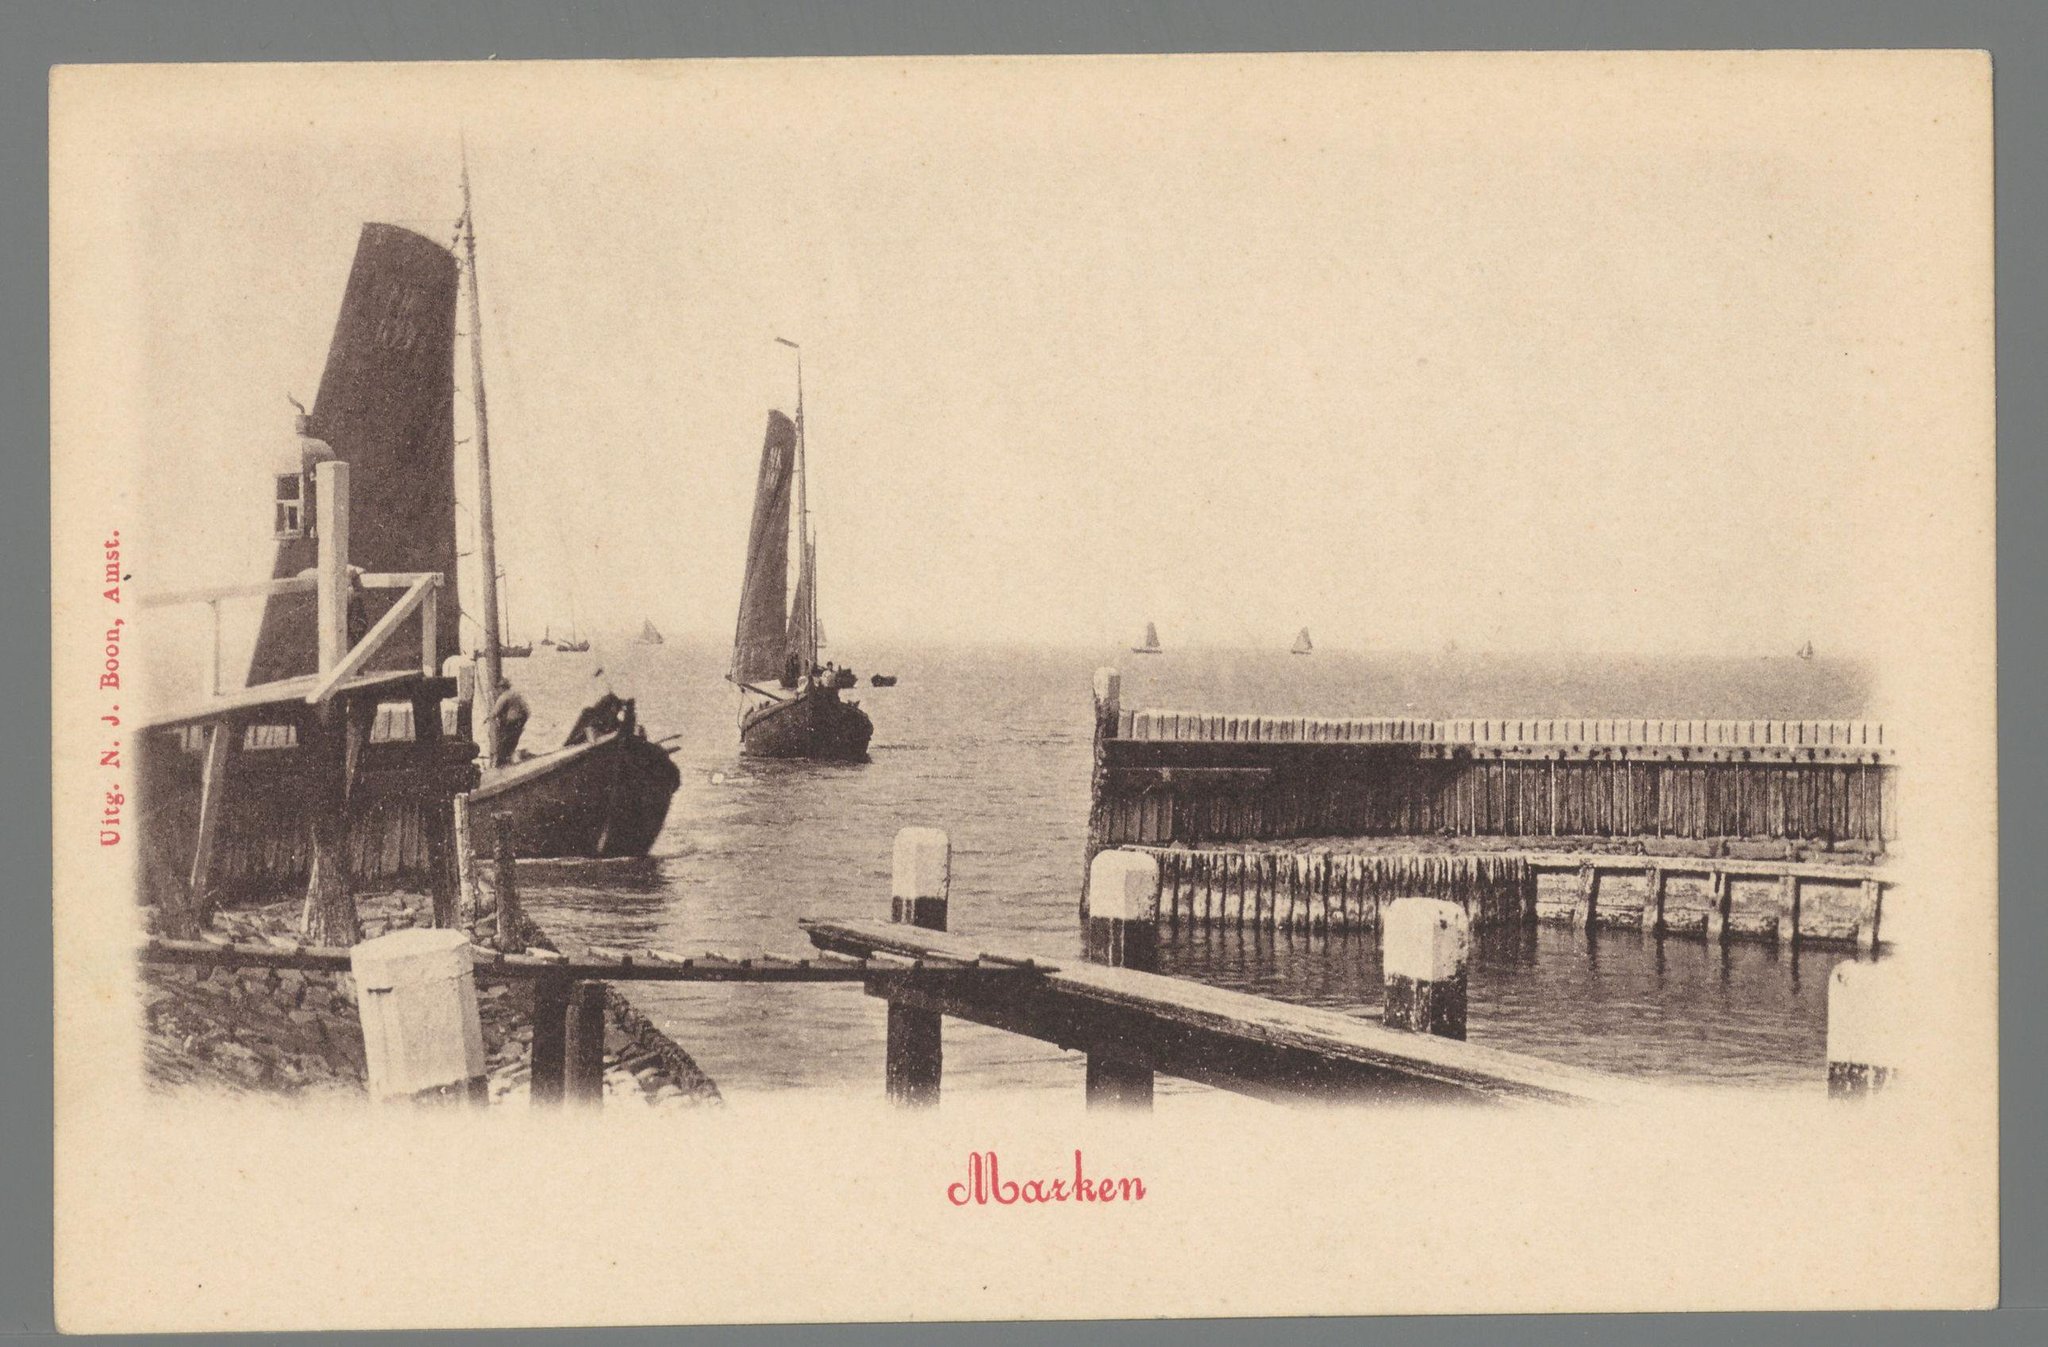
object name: photomechanical print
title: Marken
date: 1895-1901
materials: cardboard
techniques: photograph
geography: marken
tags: sailing-ship, sailing-boat, lake